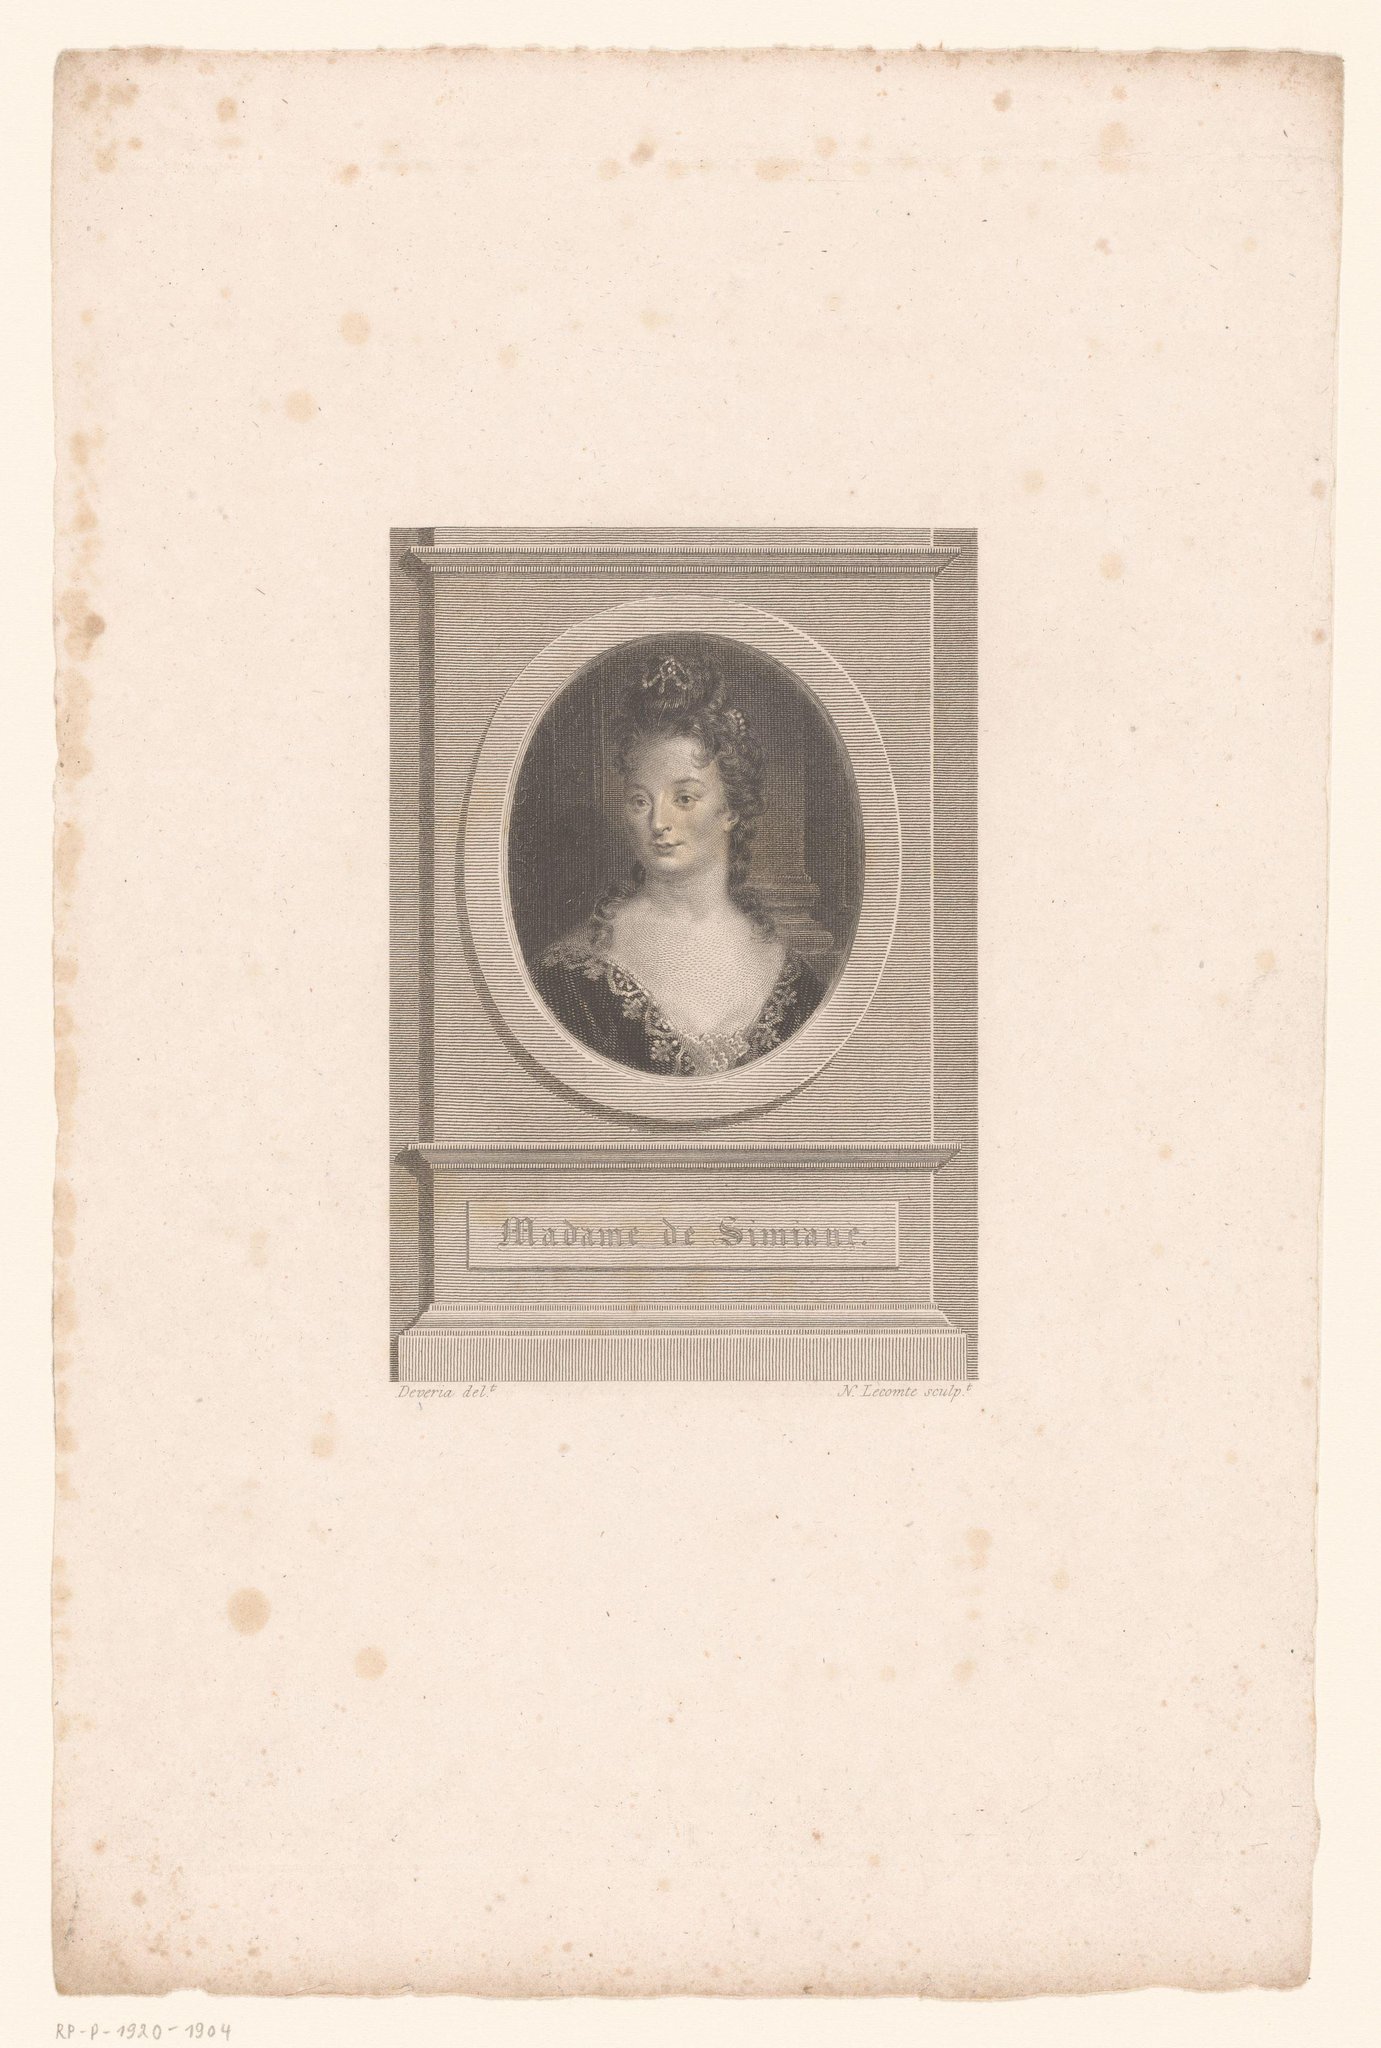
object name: print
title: Madame de Simiane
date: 1822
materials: paper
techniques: engraving, etching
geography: france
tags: paris, historical persons - bb - woman, ornament ~ medallion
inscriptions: collector's mark: Lugt 2228